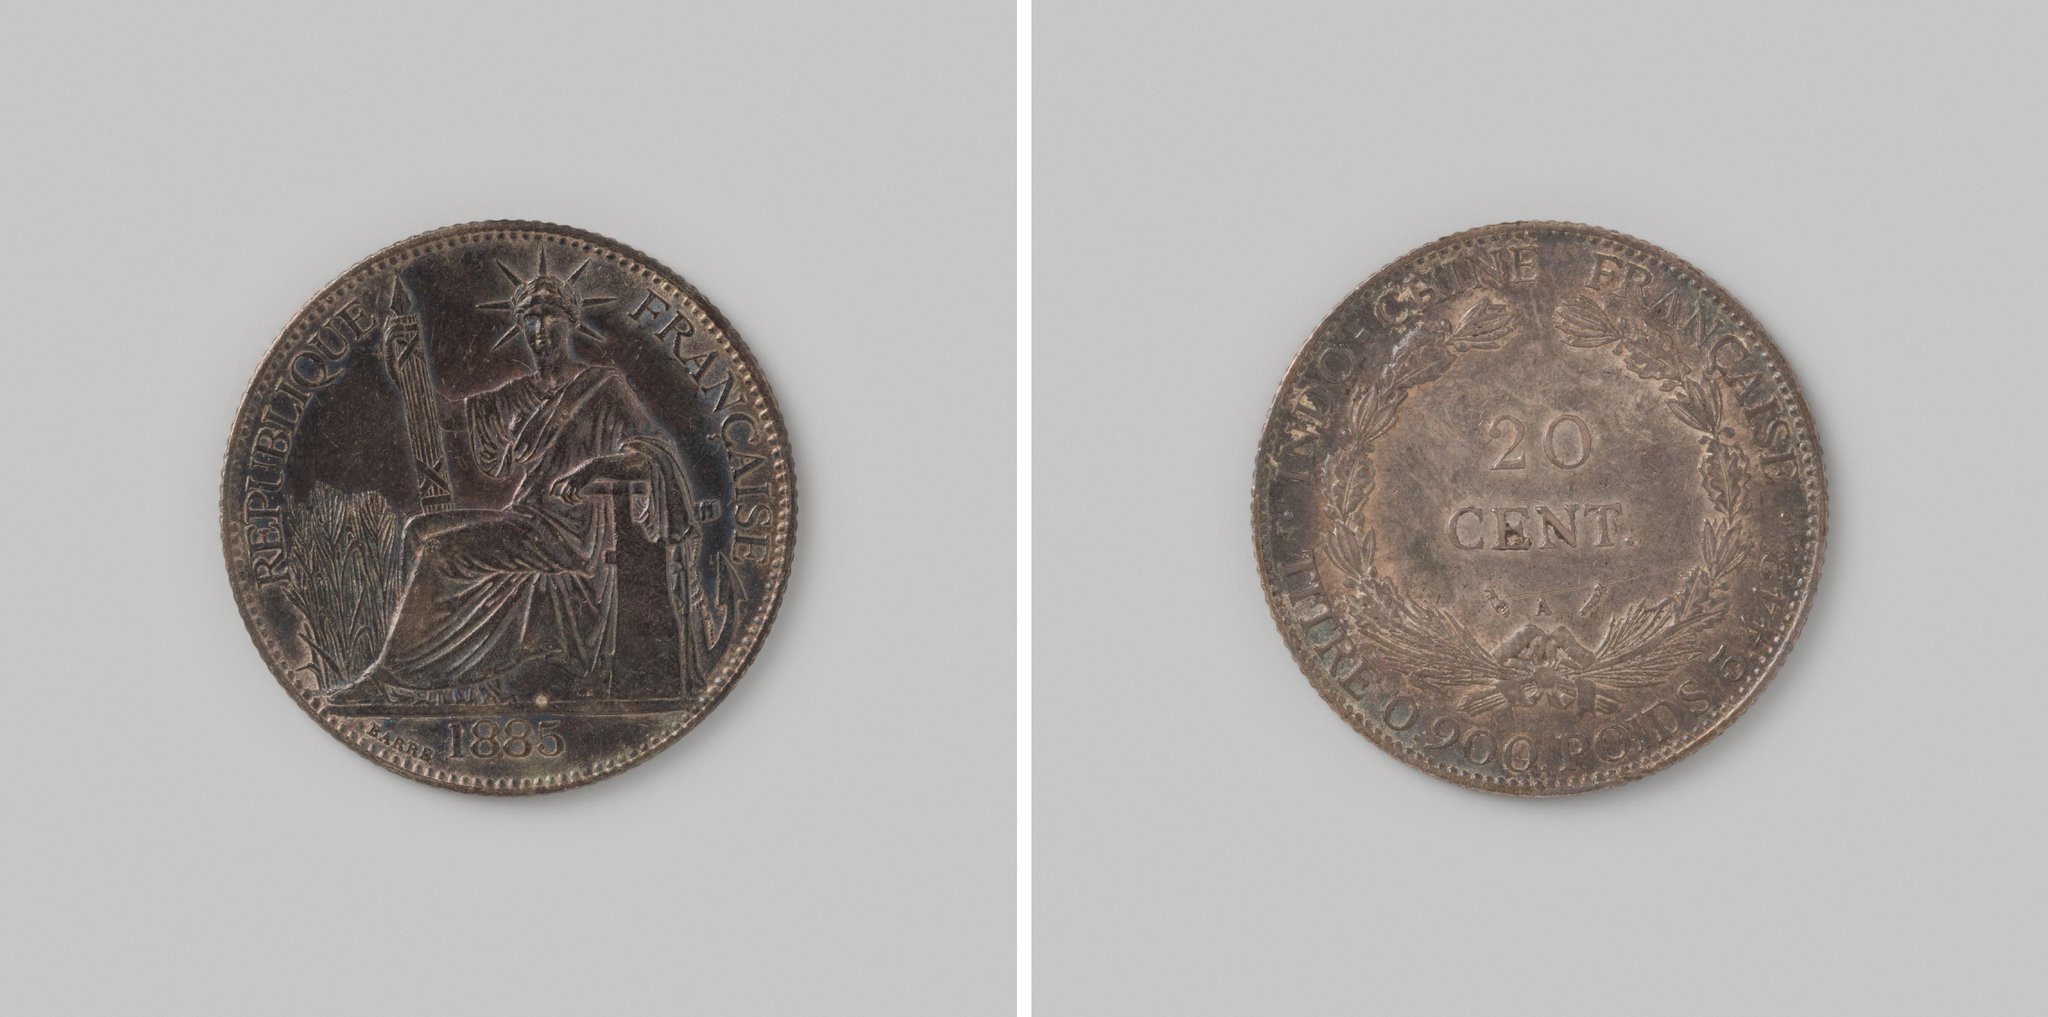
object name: coin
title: Frans Indo-China, 20 centimes, 1885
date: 1885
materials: silver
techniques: striking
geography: paris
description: Zilveren munt. Voorzijde: vrouw met stralenkrans rond haar hoofd in zetel naar links met in haar rechterhand pijlenbundel. Links van haar takken en rechts anker. In afsnede jaartal. Keerzijde: tussen twee samengebonden takken in twee regels waarde-aanduiding: 20 cent., waaronder letter A [=Parijs]. In omschrift onderaan gehalte- en gewichts-aanduiding. Kartelrand.